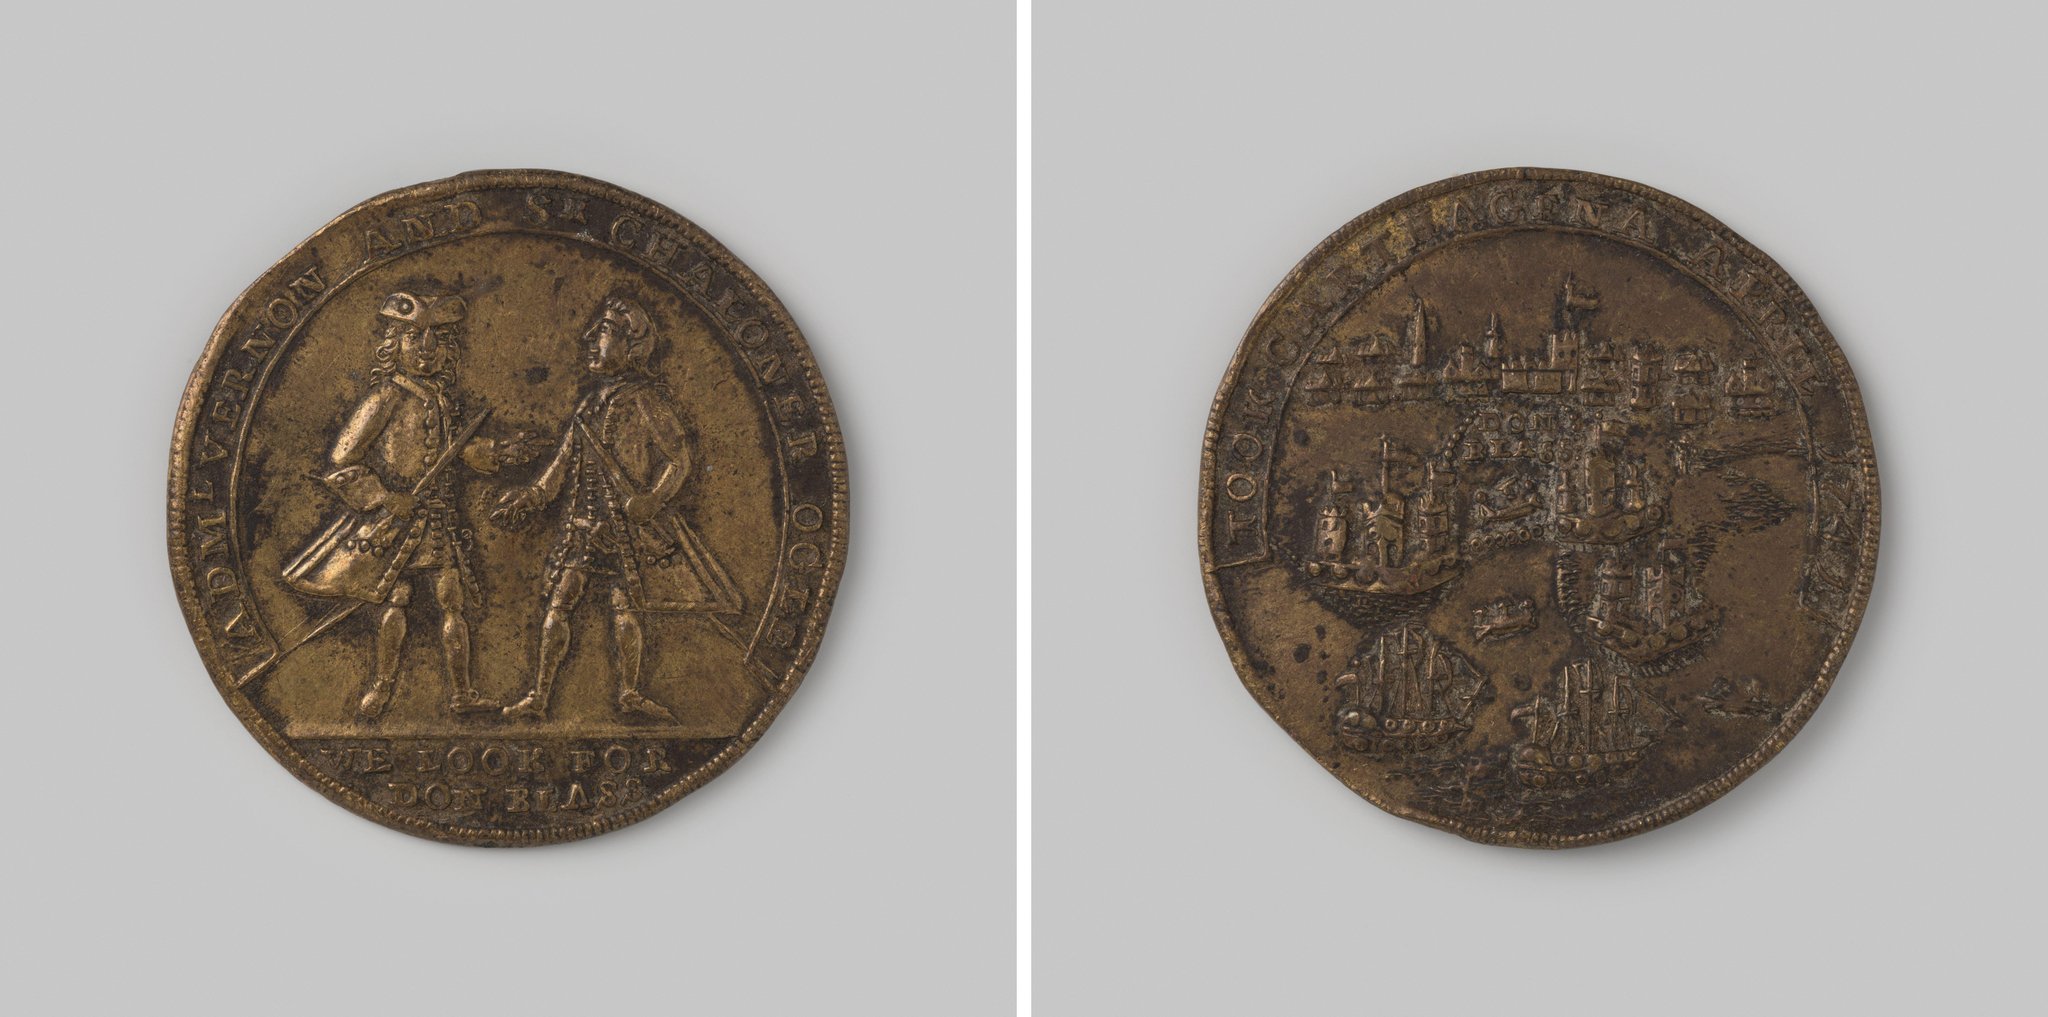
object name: history medal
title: Inname van Carthagena door Admiraal Vernon en Chaloner Ogle 1741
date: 1741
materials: brass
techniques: striking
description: Verguld messing penning, op de voorzijde Vernon en Ogle staand, met omschrift en afsnedetekst, op de keerzijde de vloot voor de haven van Cartagena met zijn kastelen, met omschrift.